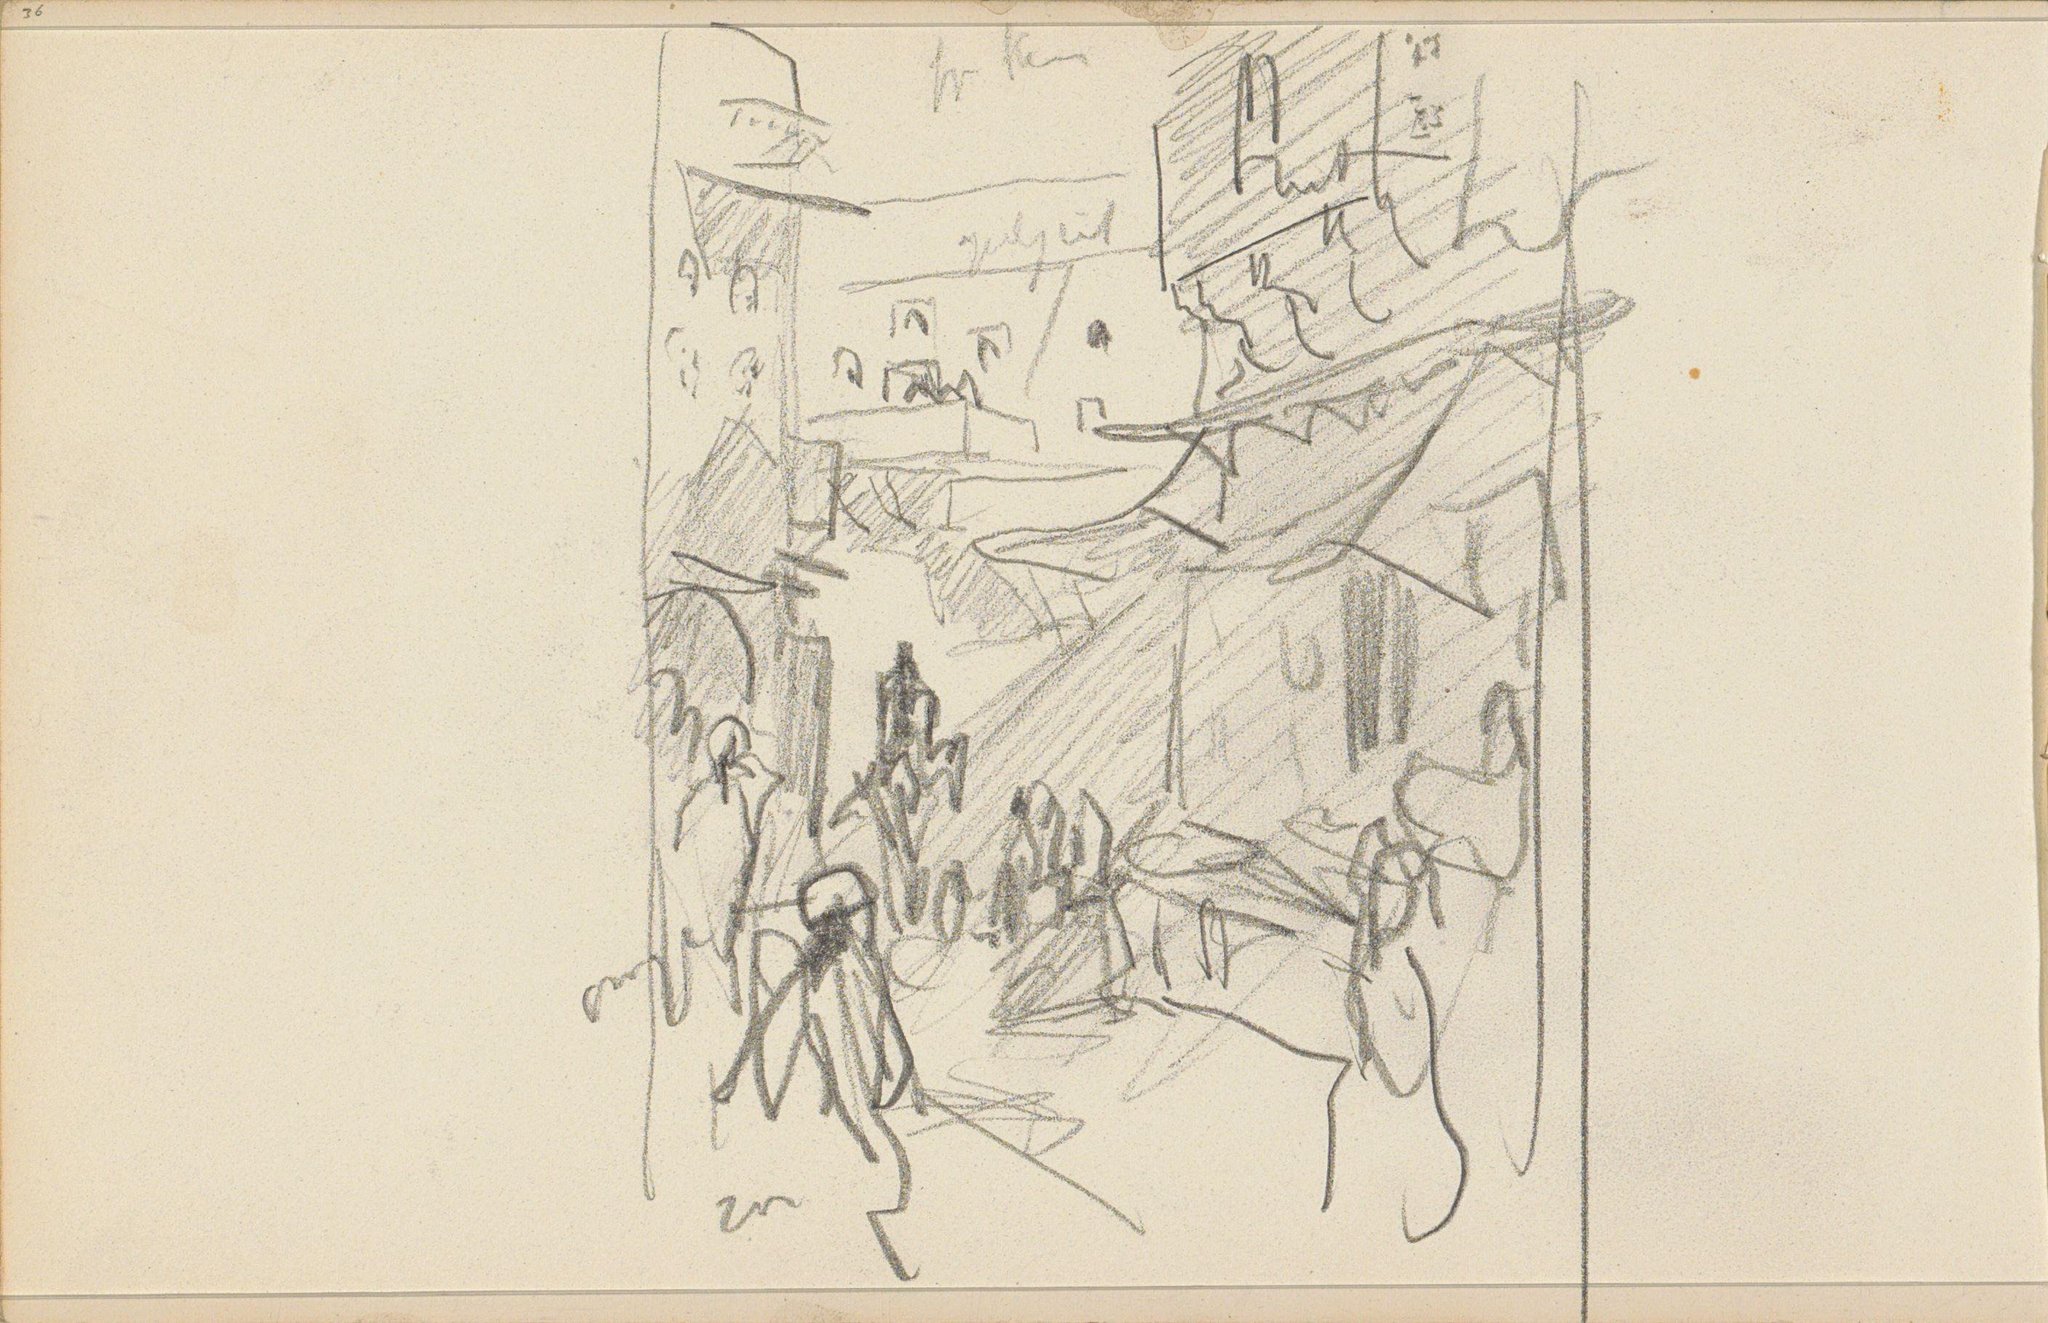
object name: sketchbook leaf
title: Indiase straatscène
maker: marius bauer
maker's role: draughtsman, print maker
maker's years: 1867-1932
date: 1924-1925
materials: paper, pencil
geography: india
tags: street (+ city(-scape) with figures, staffage)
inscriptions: kleurnotitie, handgeschreven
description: Pagina 36 uit een schetsboek met 48 bladen.